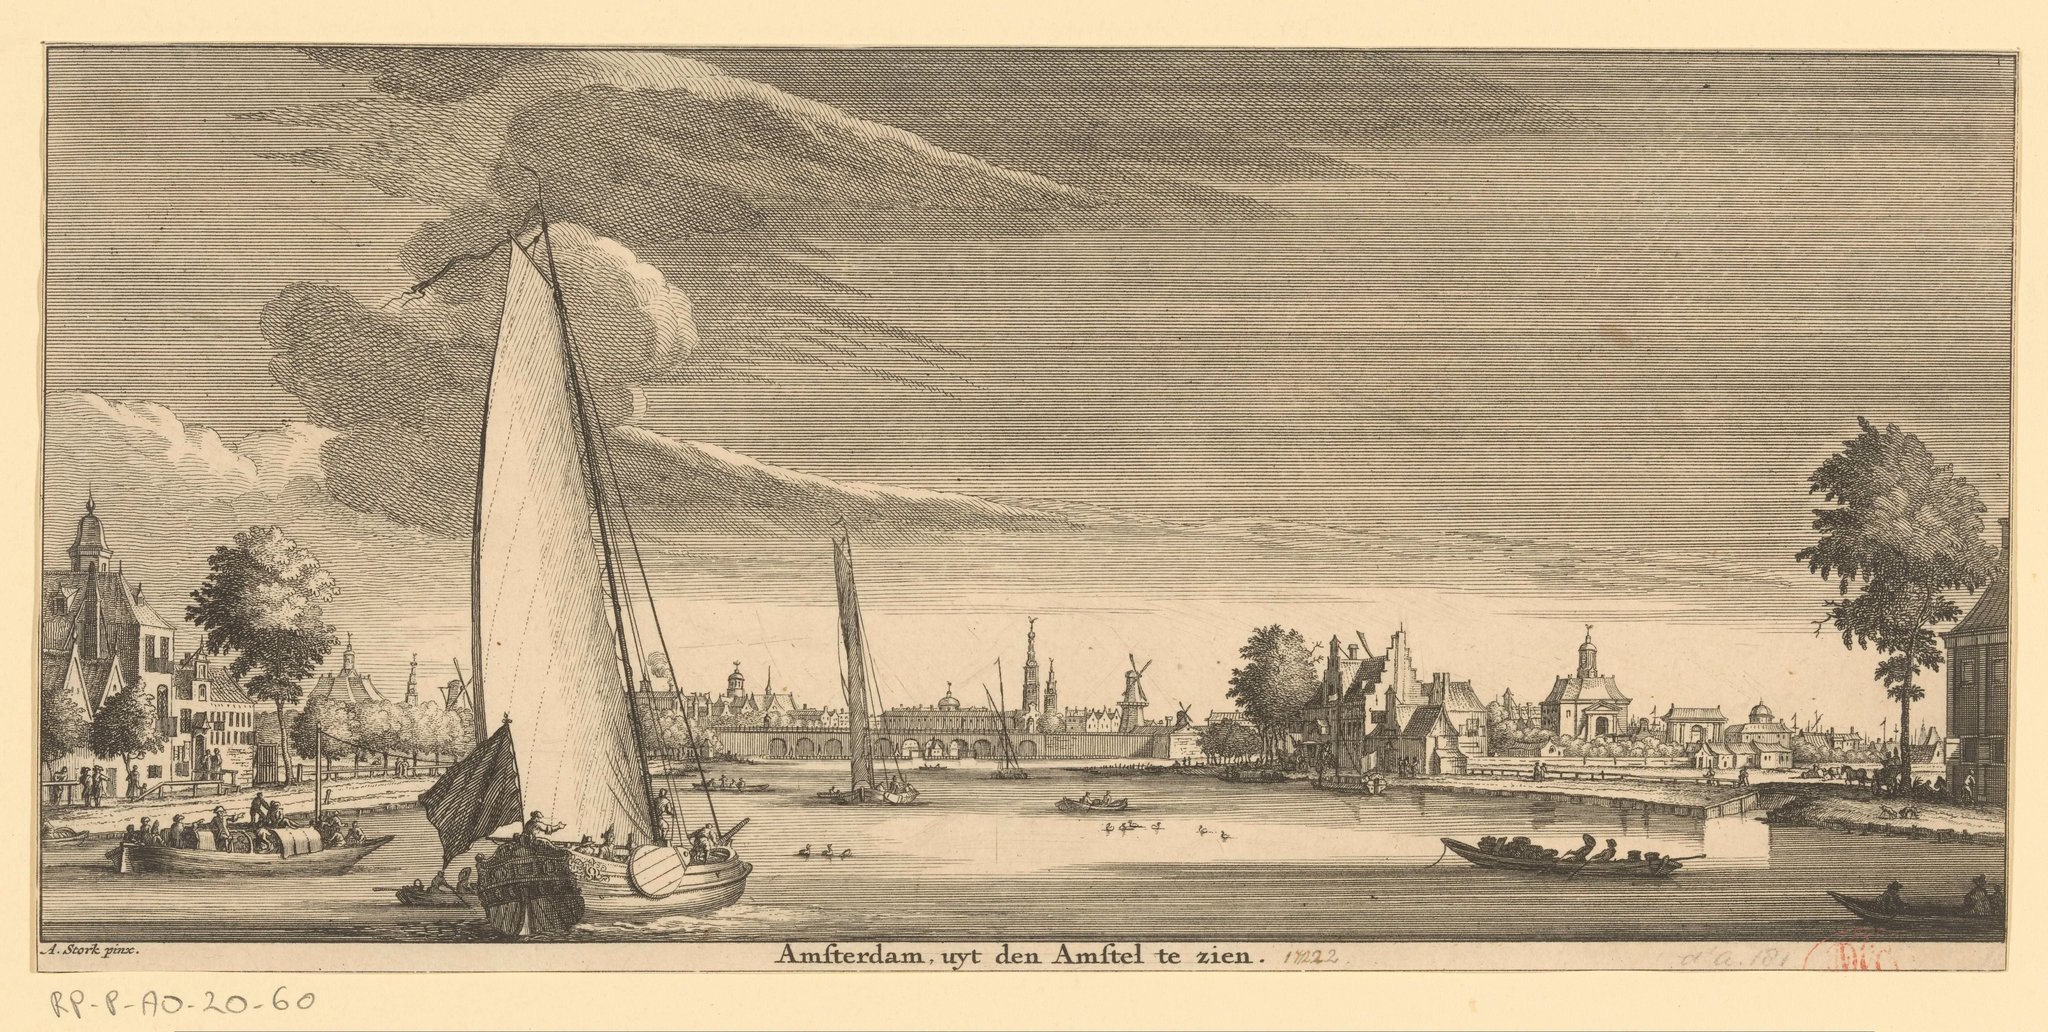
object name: book illustration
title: Amsterdam, uyt den Amstel te zien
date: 1723-1738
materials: paper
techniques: engraving, etching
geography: amsterdam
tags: prospect of city, town panorama, silhouette of city, amsterdam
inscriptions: collector's mark: Lugt 195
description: Prent ook gebruikt in: Willink, Daniël. Amsterdamsche Buitensingel nevens de omleggende dorpen, opgeheldert door aanteekeningen over veele voornaame geschiedeniszen: met afbeeldingen (…) / Daniël Willinks Amsterdamsche Buitensingel. Amsterdam: Andries van Damme, 1723. En in: Willink, Daniël. Amsterdamsche Buitensingel nevens de omleggende dorpen, opgeheldert door aanteekeningen over veele voornaame geschiedenissen: met afbeeldingen (…) / Daniël Willinks Amsterdamsche Buitensingel. Amsterdam: Arend van Huyssteen, 1738.